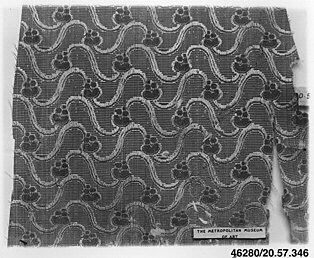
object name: piece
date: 1701-1800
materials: silk